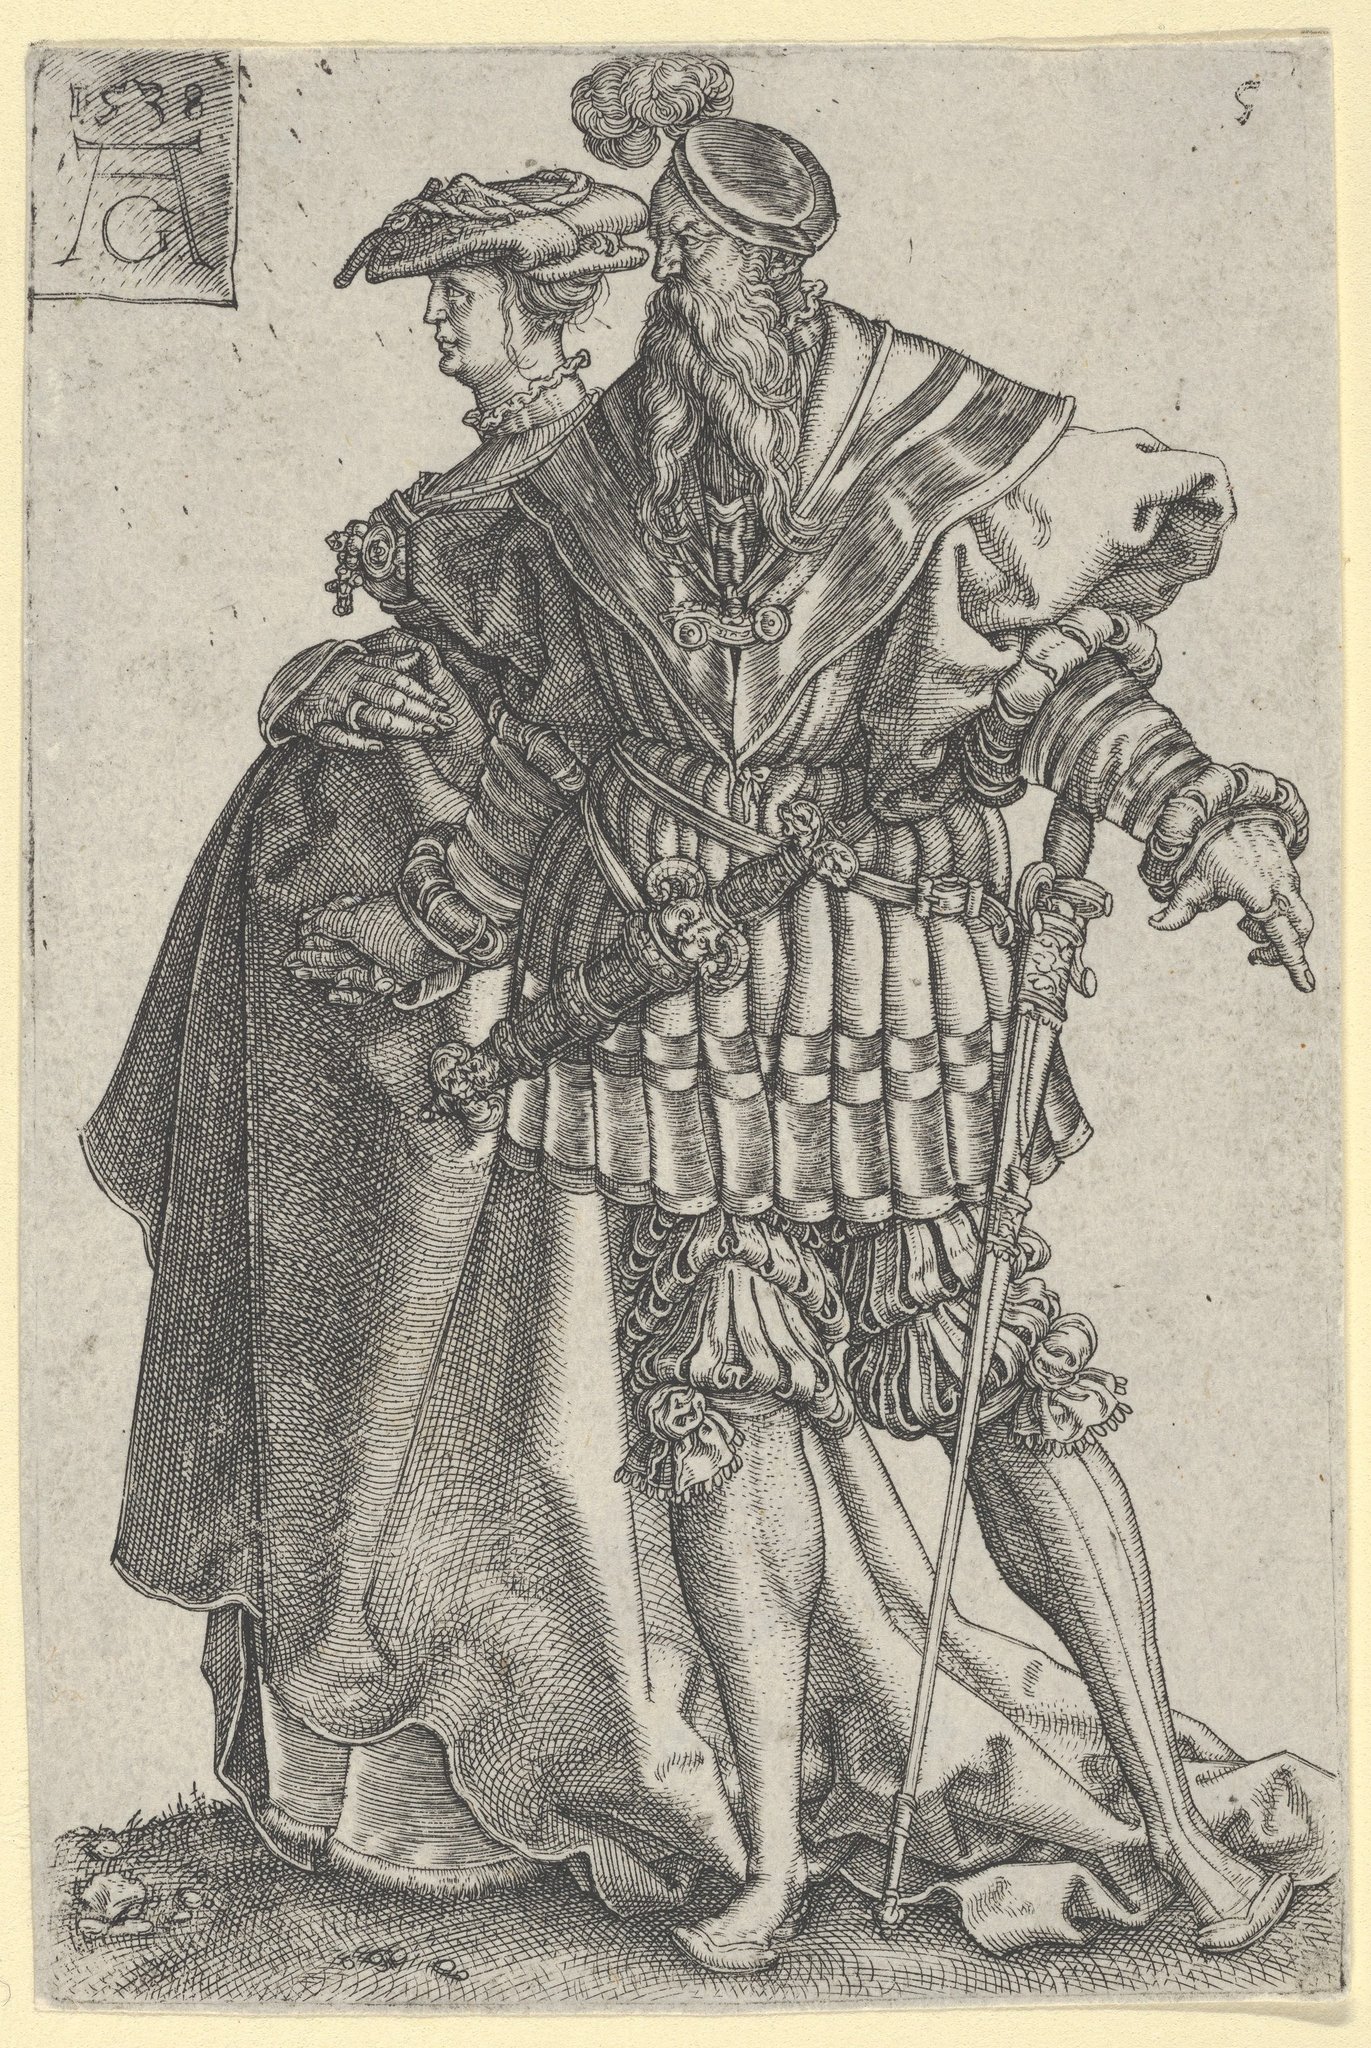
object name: print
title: Dancing Couple, from "The Large Wedding Dancers"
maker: heinrich aldegrever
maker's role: artist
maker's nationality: german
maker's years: 1502-1561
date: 1538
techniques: engraving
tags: couples,men,women,dancers